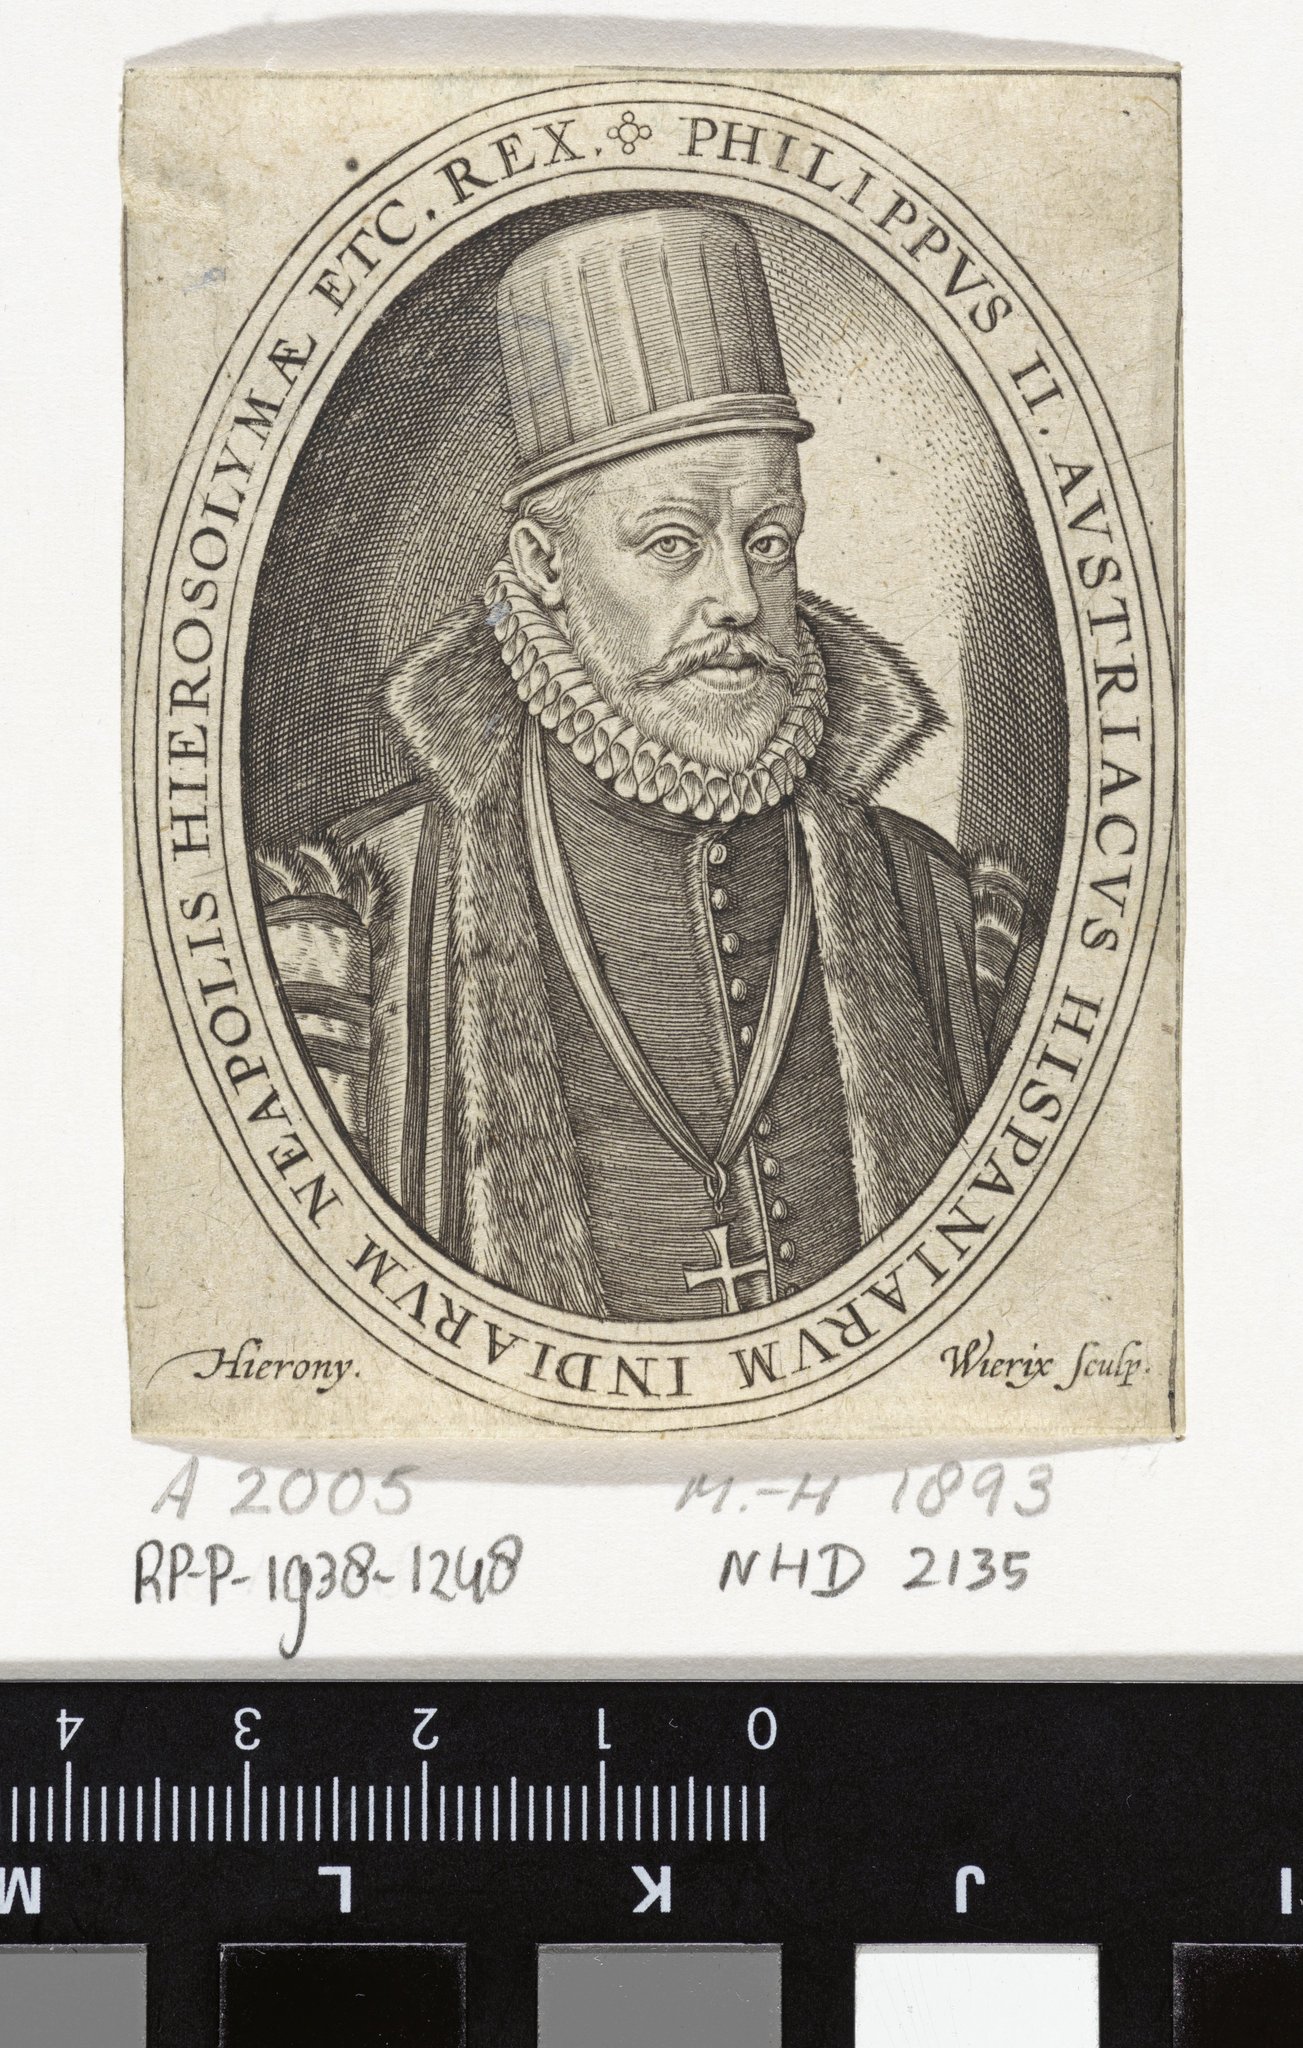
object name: print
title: Portret van Filips II, koning van Spanje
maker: hieronymus wierix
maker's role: draughtsman, print maker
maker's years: 1553-1619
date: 1586-1619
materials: paper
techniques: engraving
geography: antwerp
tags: philip ii of spain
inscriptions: collector's mark: Lugt 919bis, collector's mark: Lugt 2760, collector's mark: Lugt 2228, collector's mark: Lugt 847a